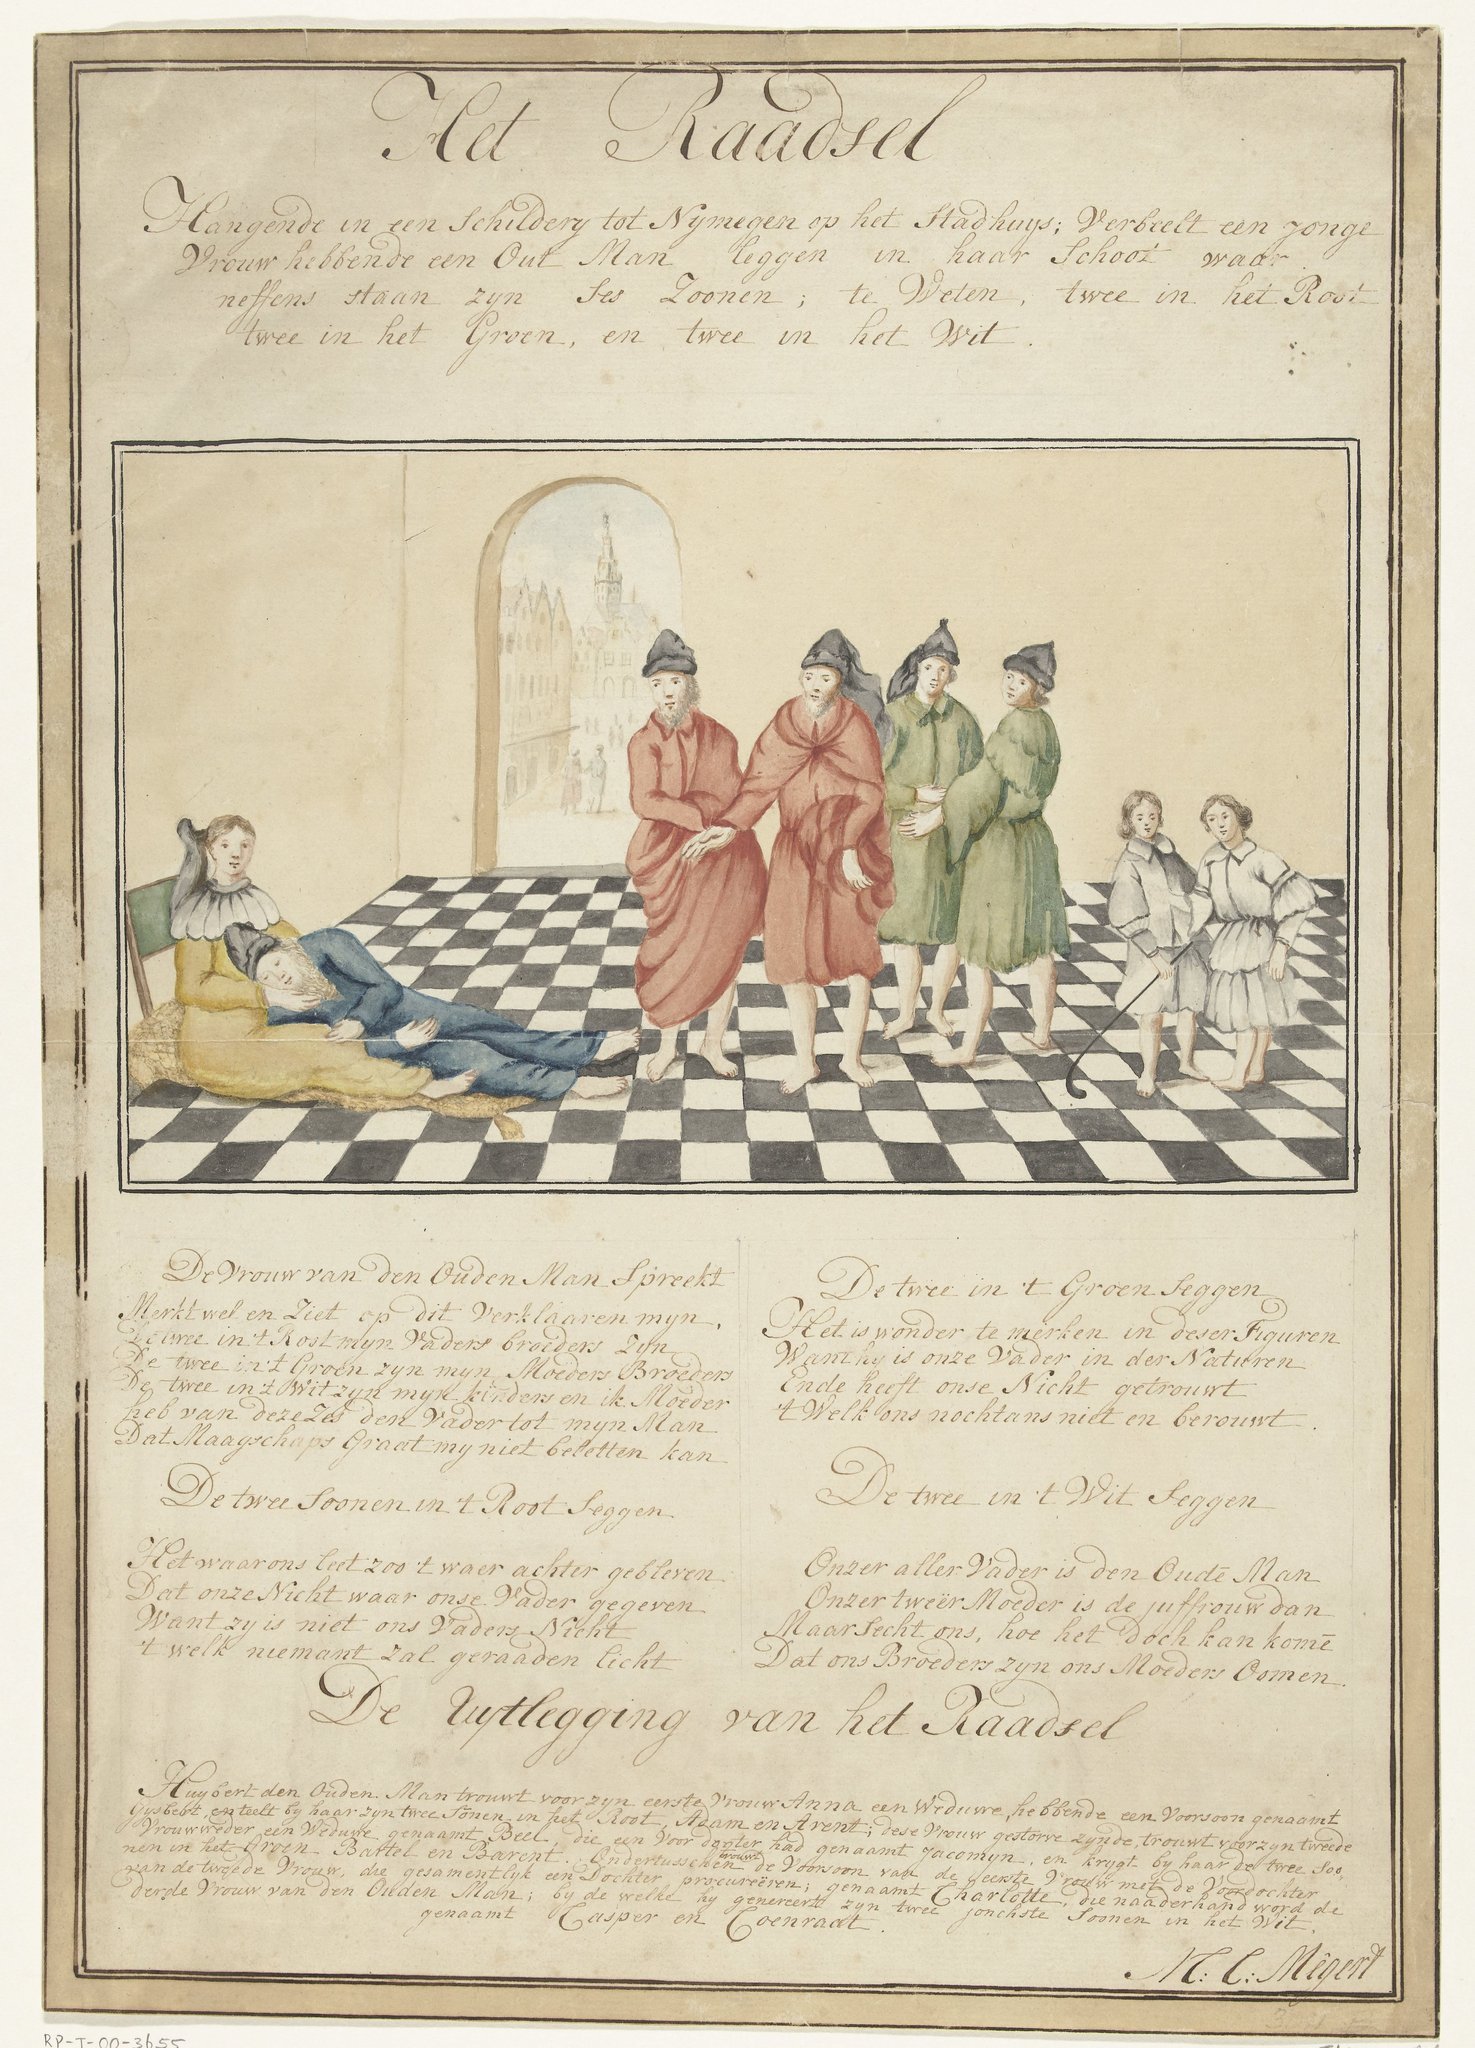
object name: drawing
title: Het Raadsel Hangende in een schildery tot Nymegen op het stadhuys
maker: h.c. mêgert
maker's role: draughtsman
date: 1690-1710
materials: paper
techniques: writing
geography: northern netherlands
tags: family relationships (first, second, third and fourth degree), generations, nijmegen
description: Het Nijmeegse Raadsel of het Gecompliceerde Huwelijk, 1619. Schilderij hangende op het raadhuis van Nijmegen met een familieportret met ingewikkelde relaties afkomstig uit een huwelijk aldaar gesloten in 1619. Met vier verzen en het uitleg van de raadsel op het blad onder de voorstelling.